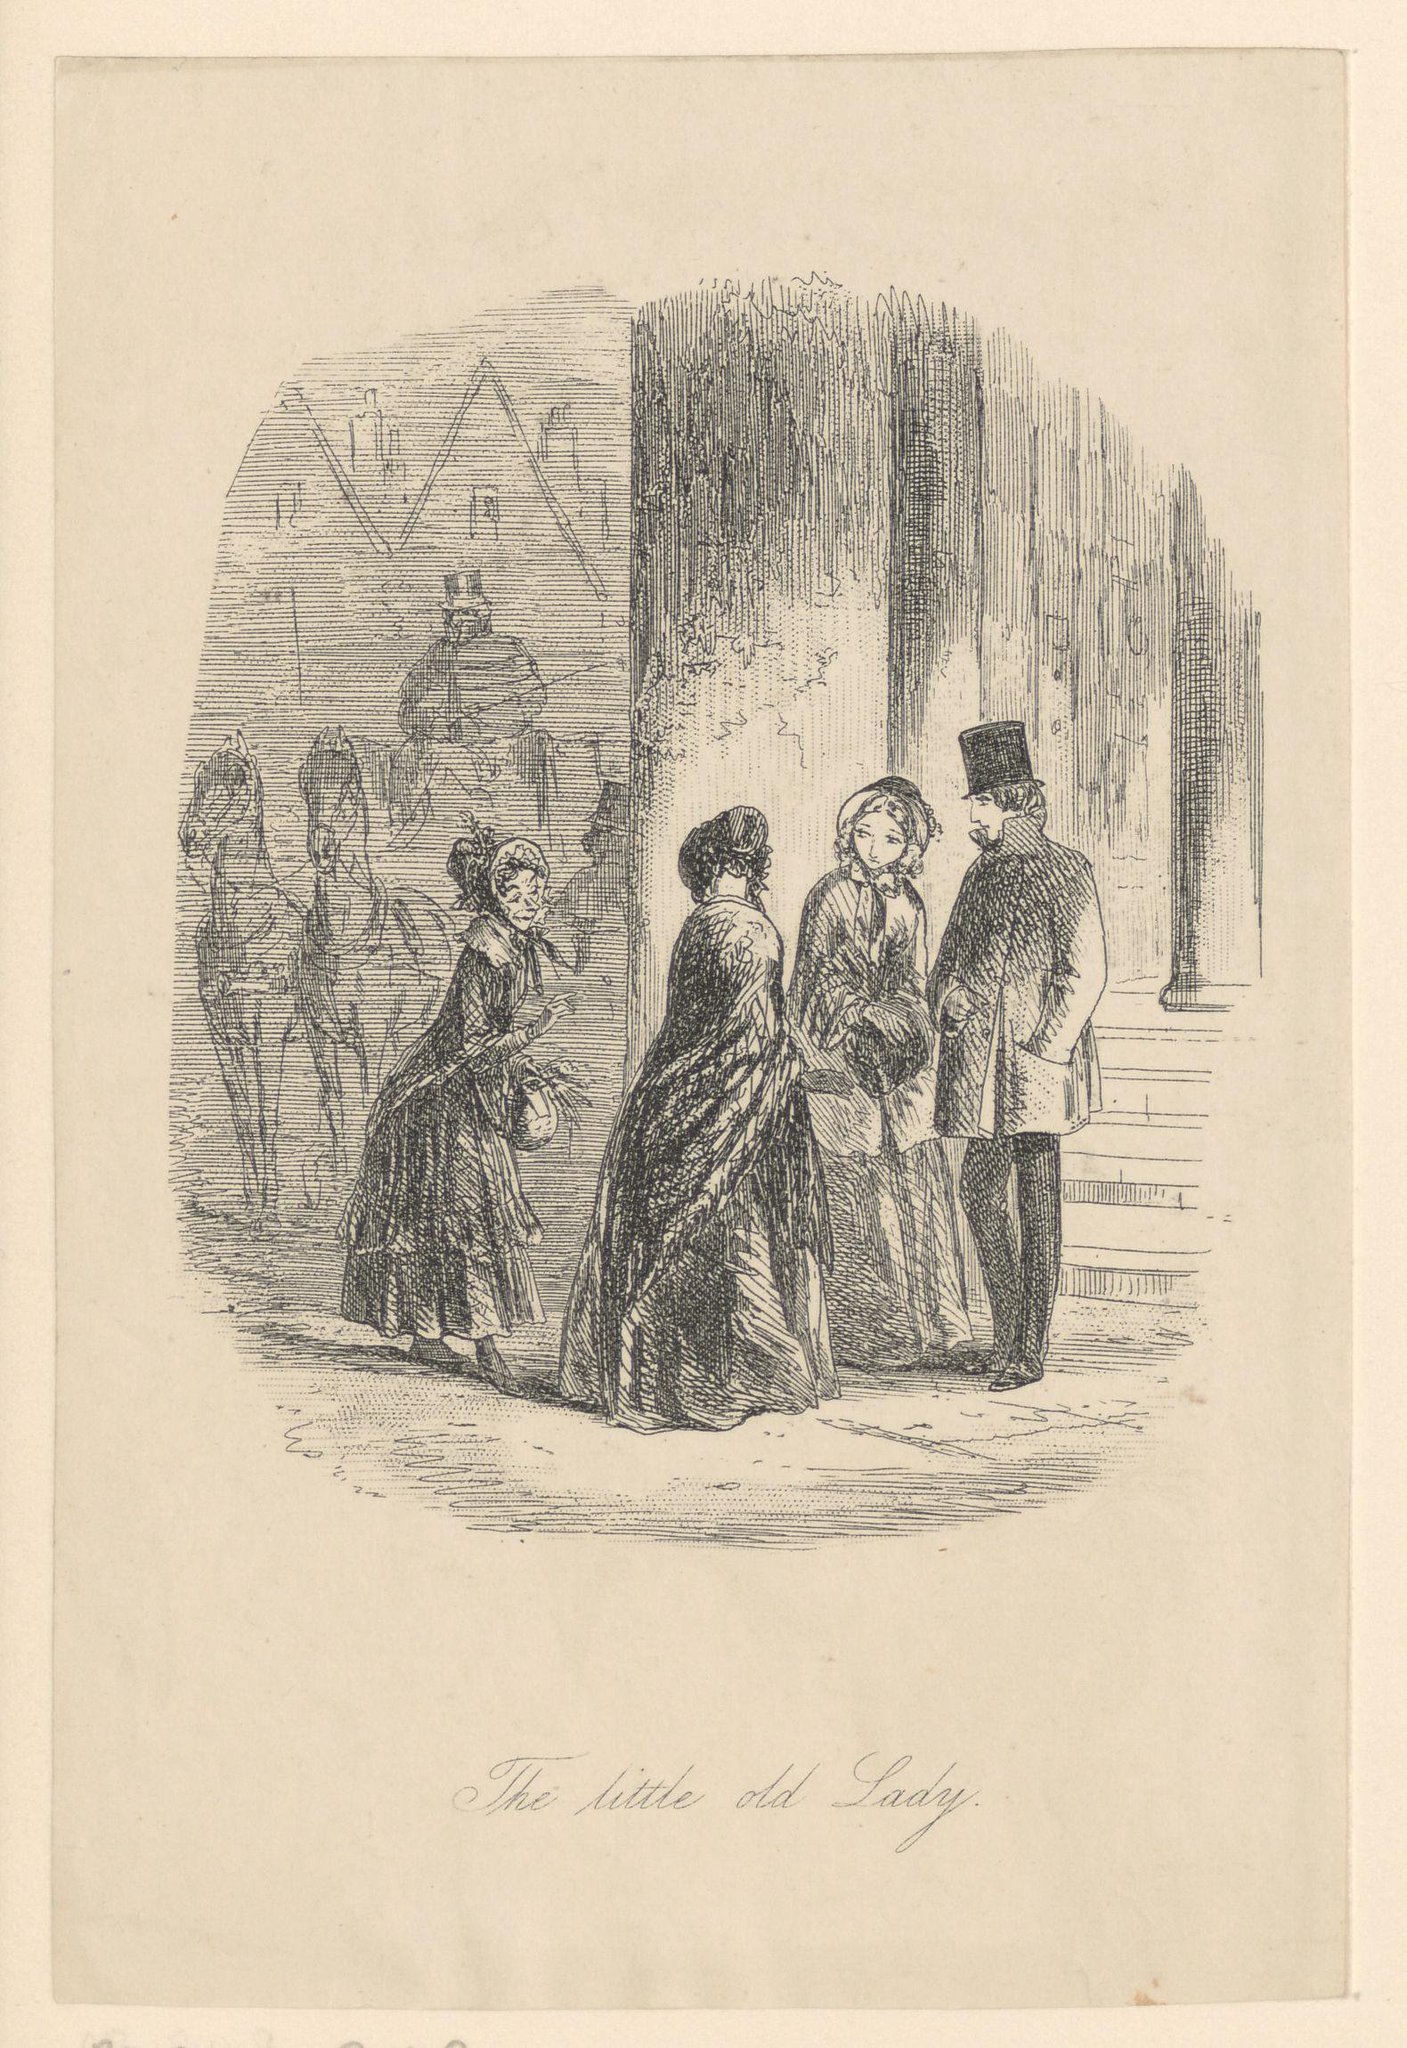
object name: print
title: The little old Lady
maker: hablot knight browne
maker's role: print maker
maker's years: 1815-1882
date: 1853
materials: paper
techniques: etching, roulette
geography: london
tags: old woman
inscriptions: collector's mark: Lugt 2228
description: Prent uit: Dickens, Charles. Bleak House. Londen: Bradbury & Evans, 1853, p. 23.